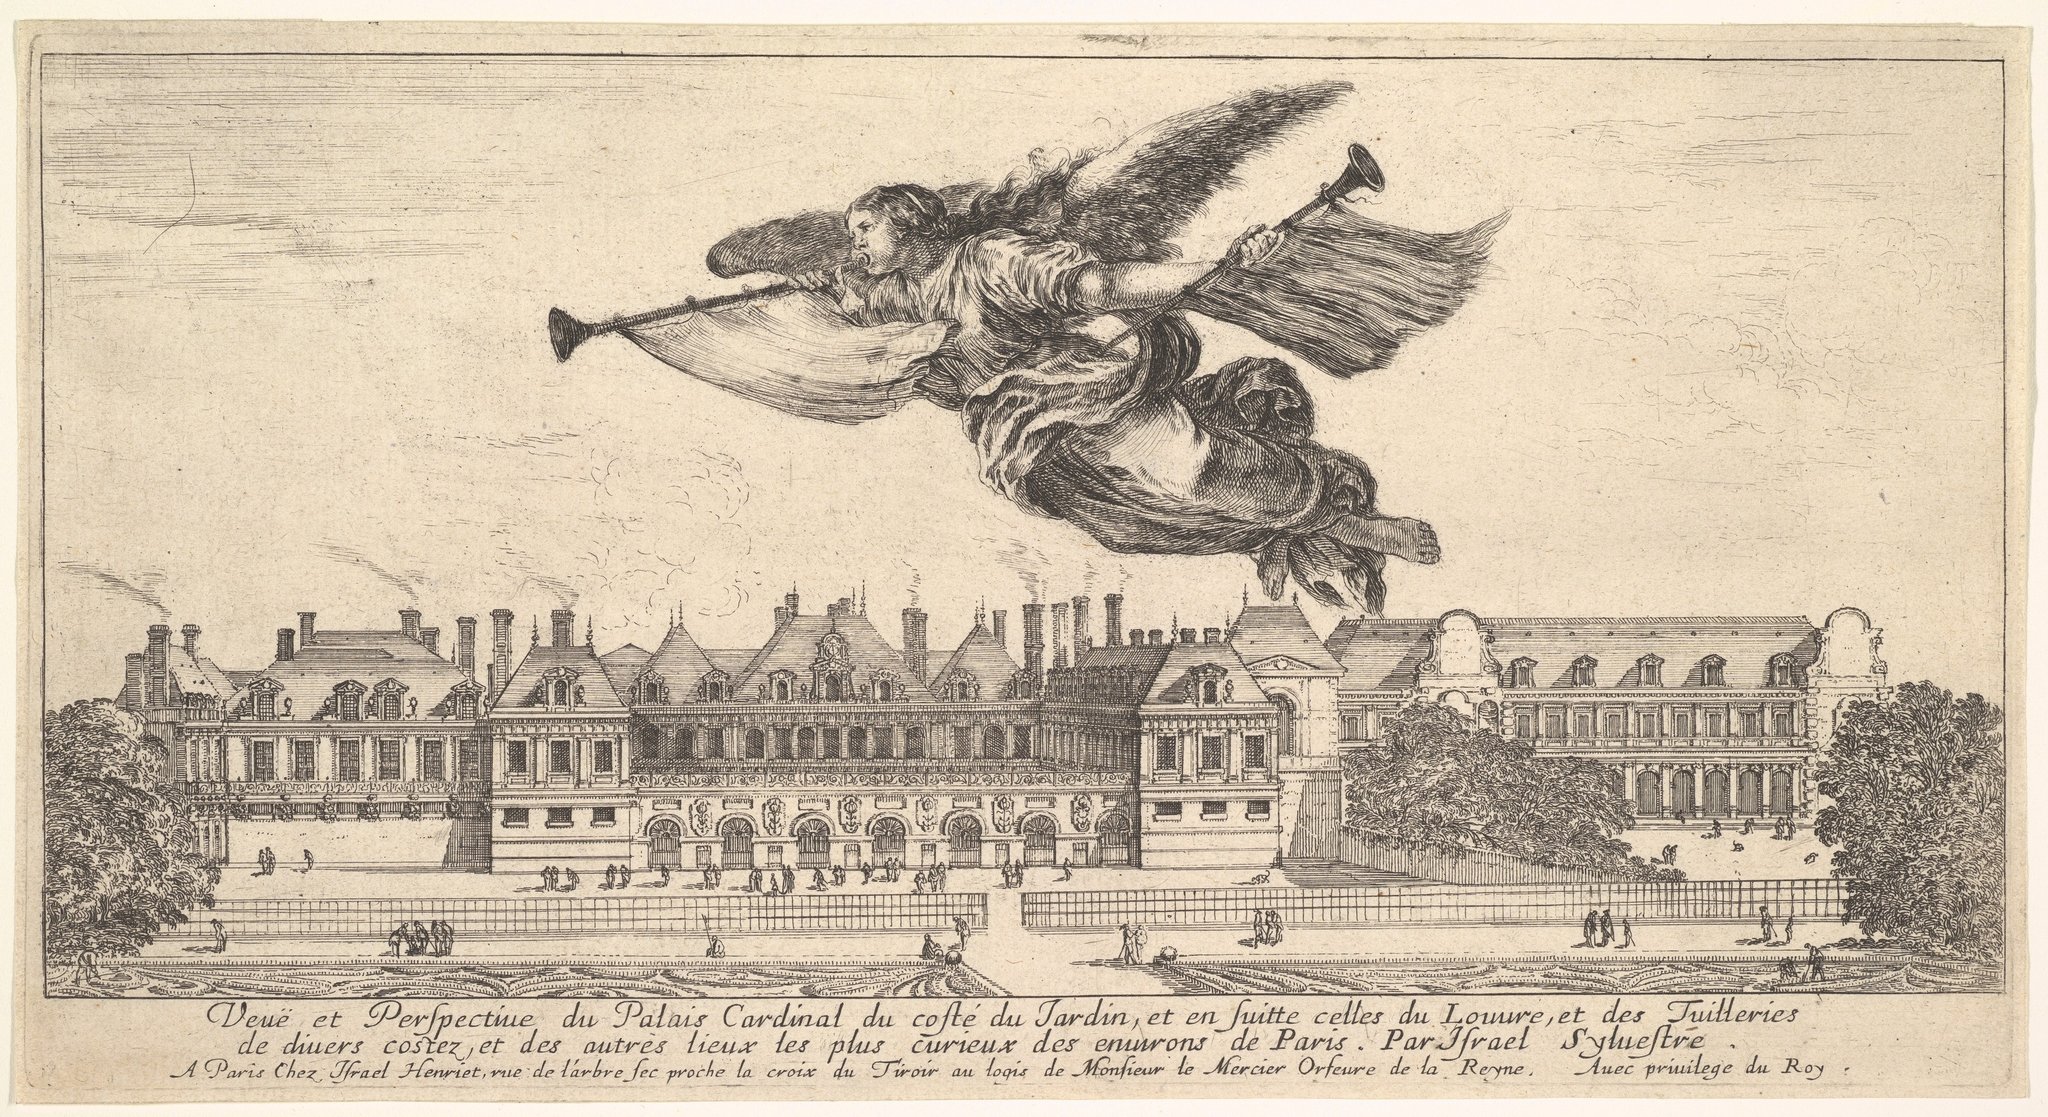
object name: print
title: View of the Palais Cardinal, from "Various views of remarkable palaces in Italy and France" (Diverses vues d'endroits remarquables d'Italie et de France)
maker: stefano della bella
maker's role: artist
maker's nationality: italian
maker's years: 1610-1664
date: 1649-1651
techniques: etching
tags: palaces,trumpets